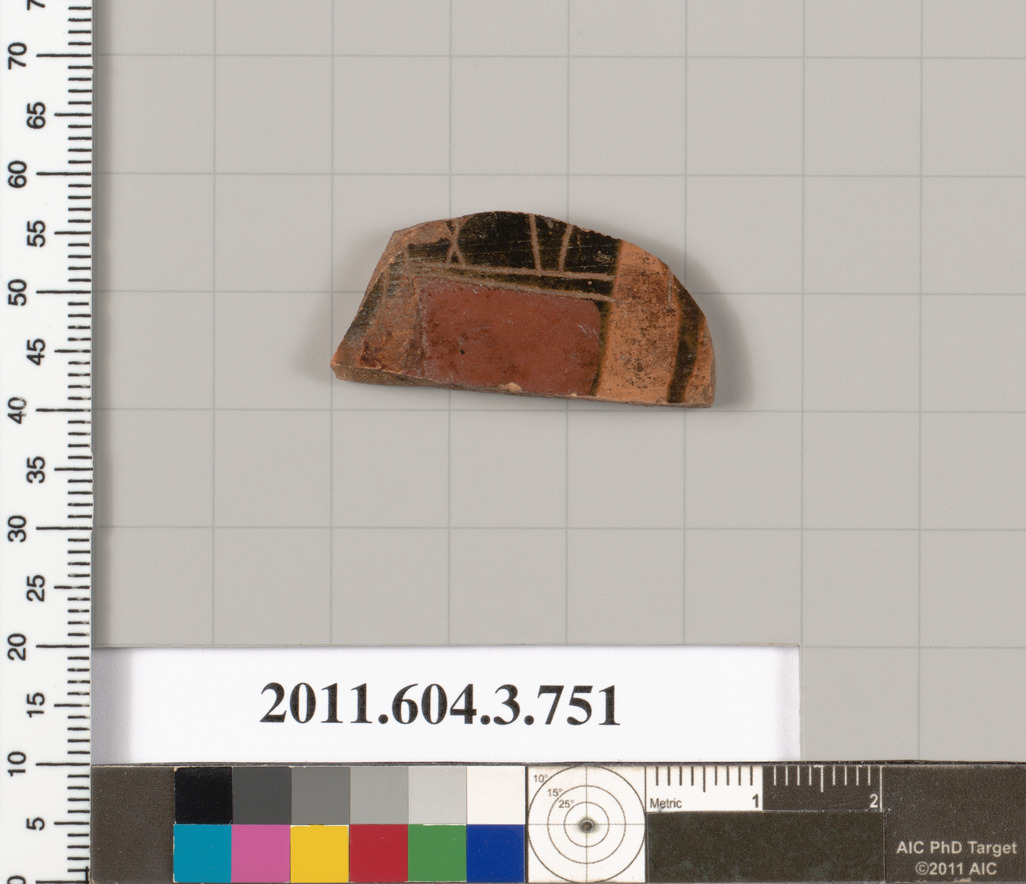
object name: neck amphora, tyrrhenian fragment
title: Terracotta fragment of a neck-amphora (jar)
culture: greek, attic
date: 575-551 BCE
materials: terracotta